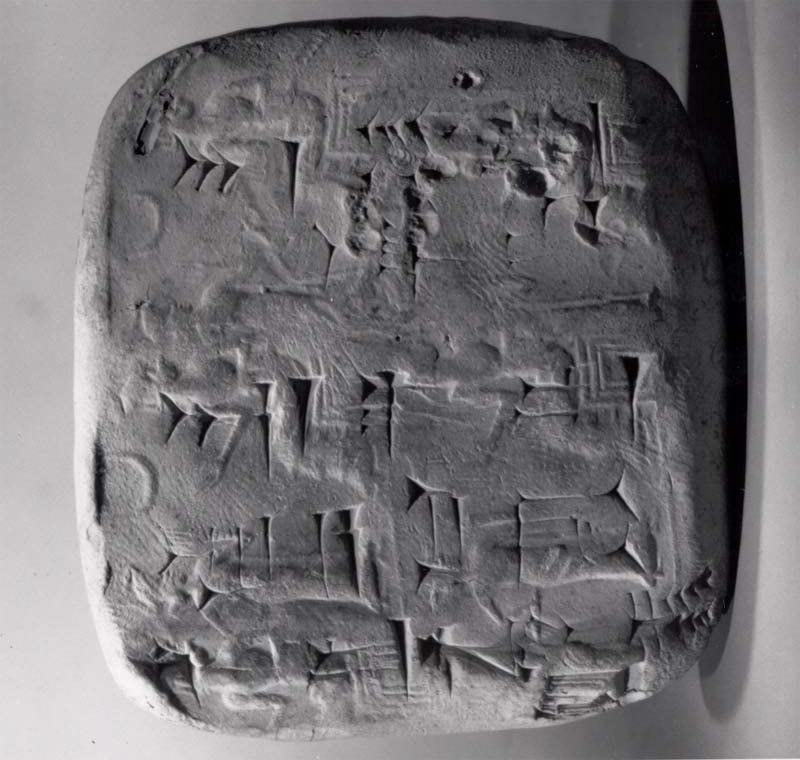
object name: cuneiform tablet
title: Cuneiform tablet impressed with cylinder seal: shipment of barley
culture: neo-sumerian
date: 2029 BCE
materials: clay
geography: mesopotamia